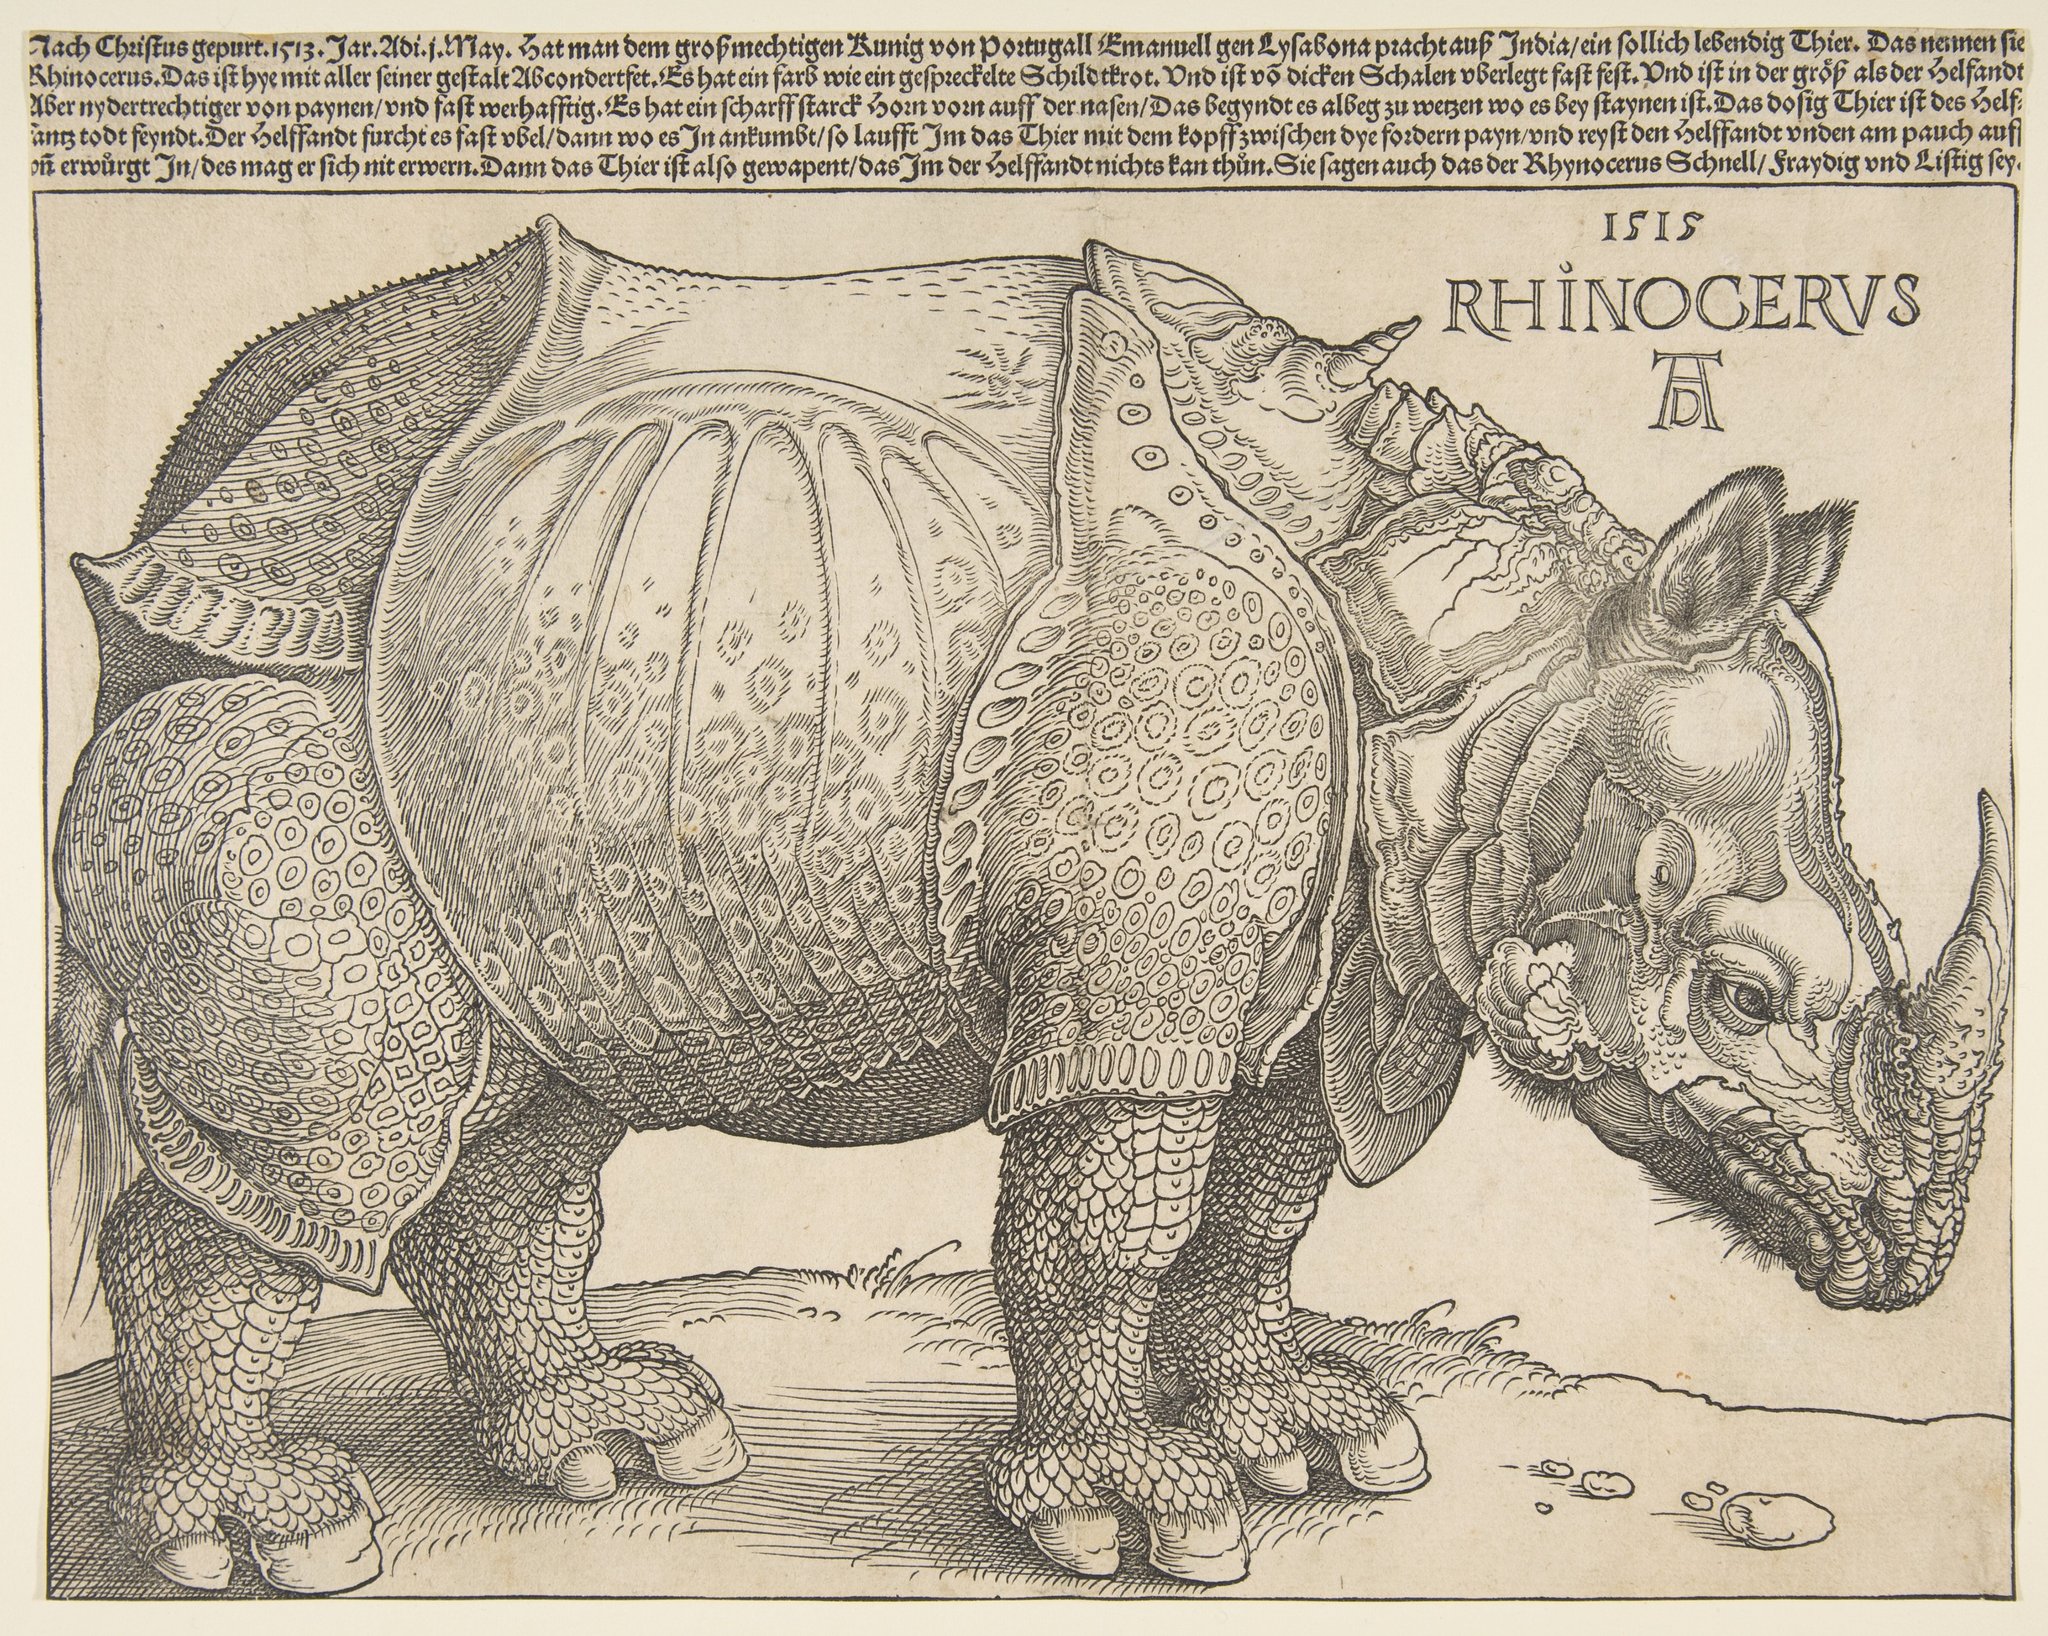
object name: print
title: The Rhinoceros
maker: albrecht dürer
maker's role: artist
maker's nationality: german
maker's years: 1471-1528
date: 1515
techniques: woodcut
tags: rhinoceros